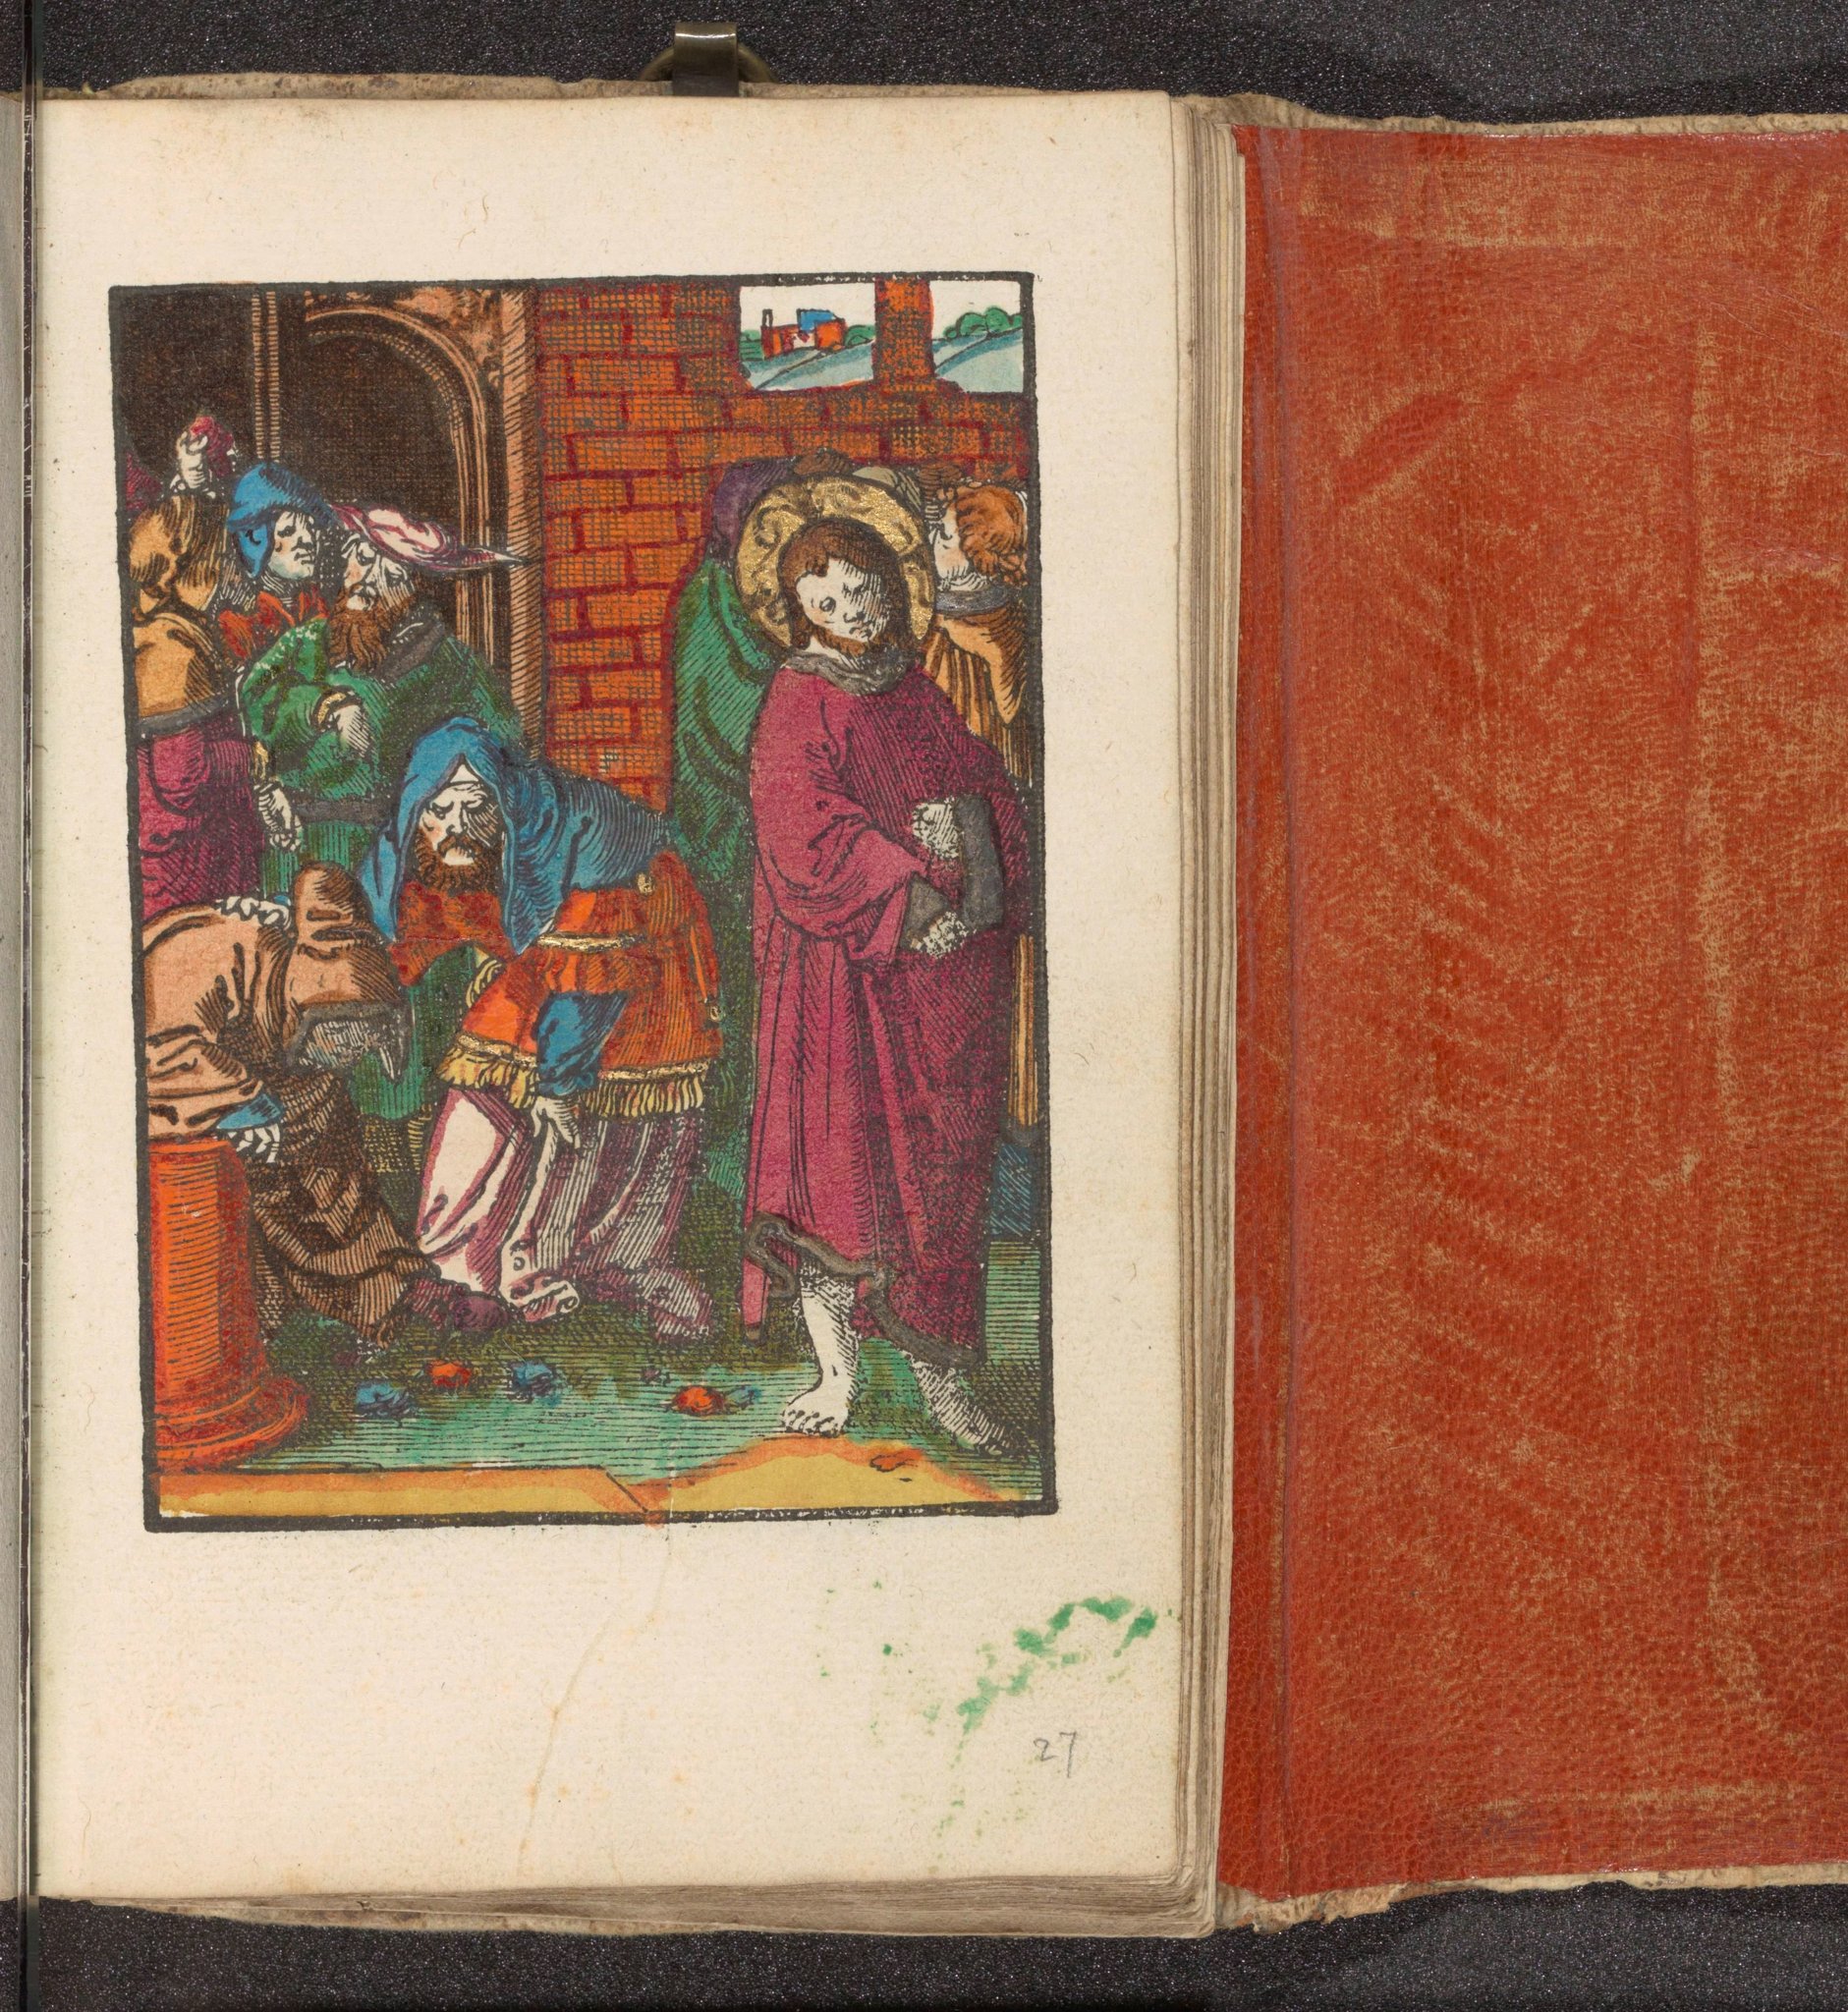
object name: album leaf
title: Joden dreigen Christus te stenigen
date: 1530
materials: paper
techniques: hand coloring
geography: amsterdam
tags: book in which illustrations are essential, attempts to stone christ (john 8:59, 10:31-33)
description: Christus verlaat de tempel. Zijn leerlingen staan achter hem. De joden rapen stenen op om Christus te stenigen wegens godslastering. Prent maakt deel uit van een boek.